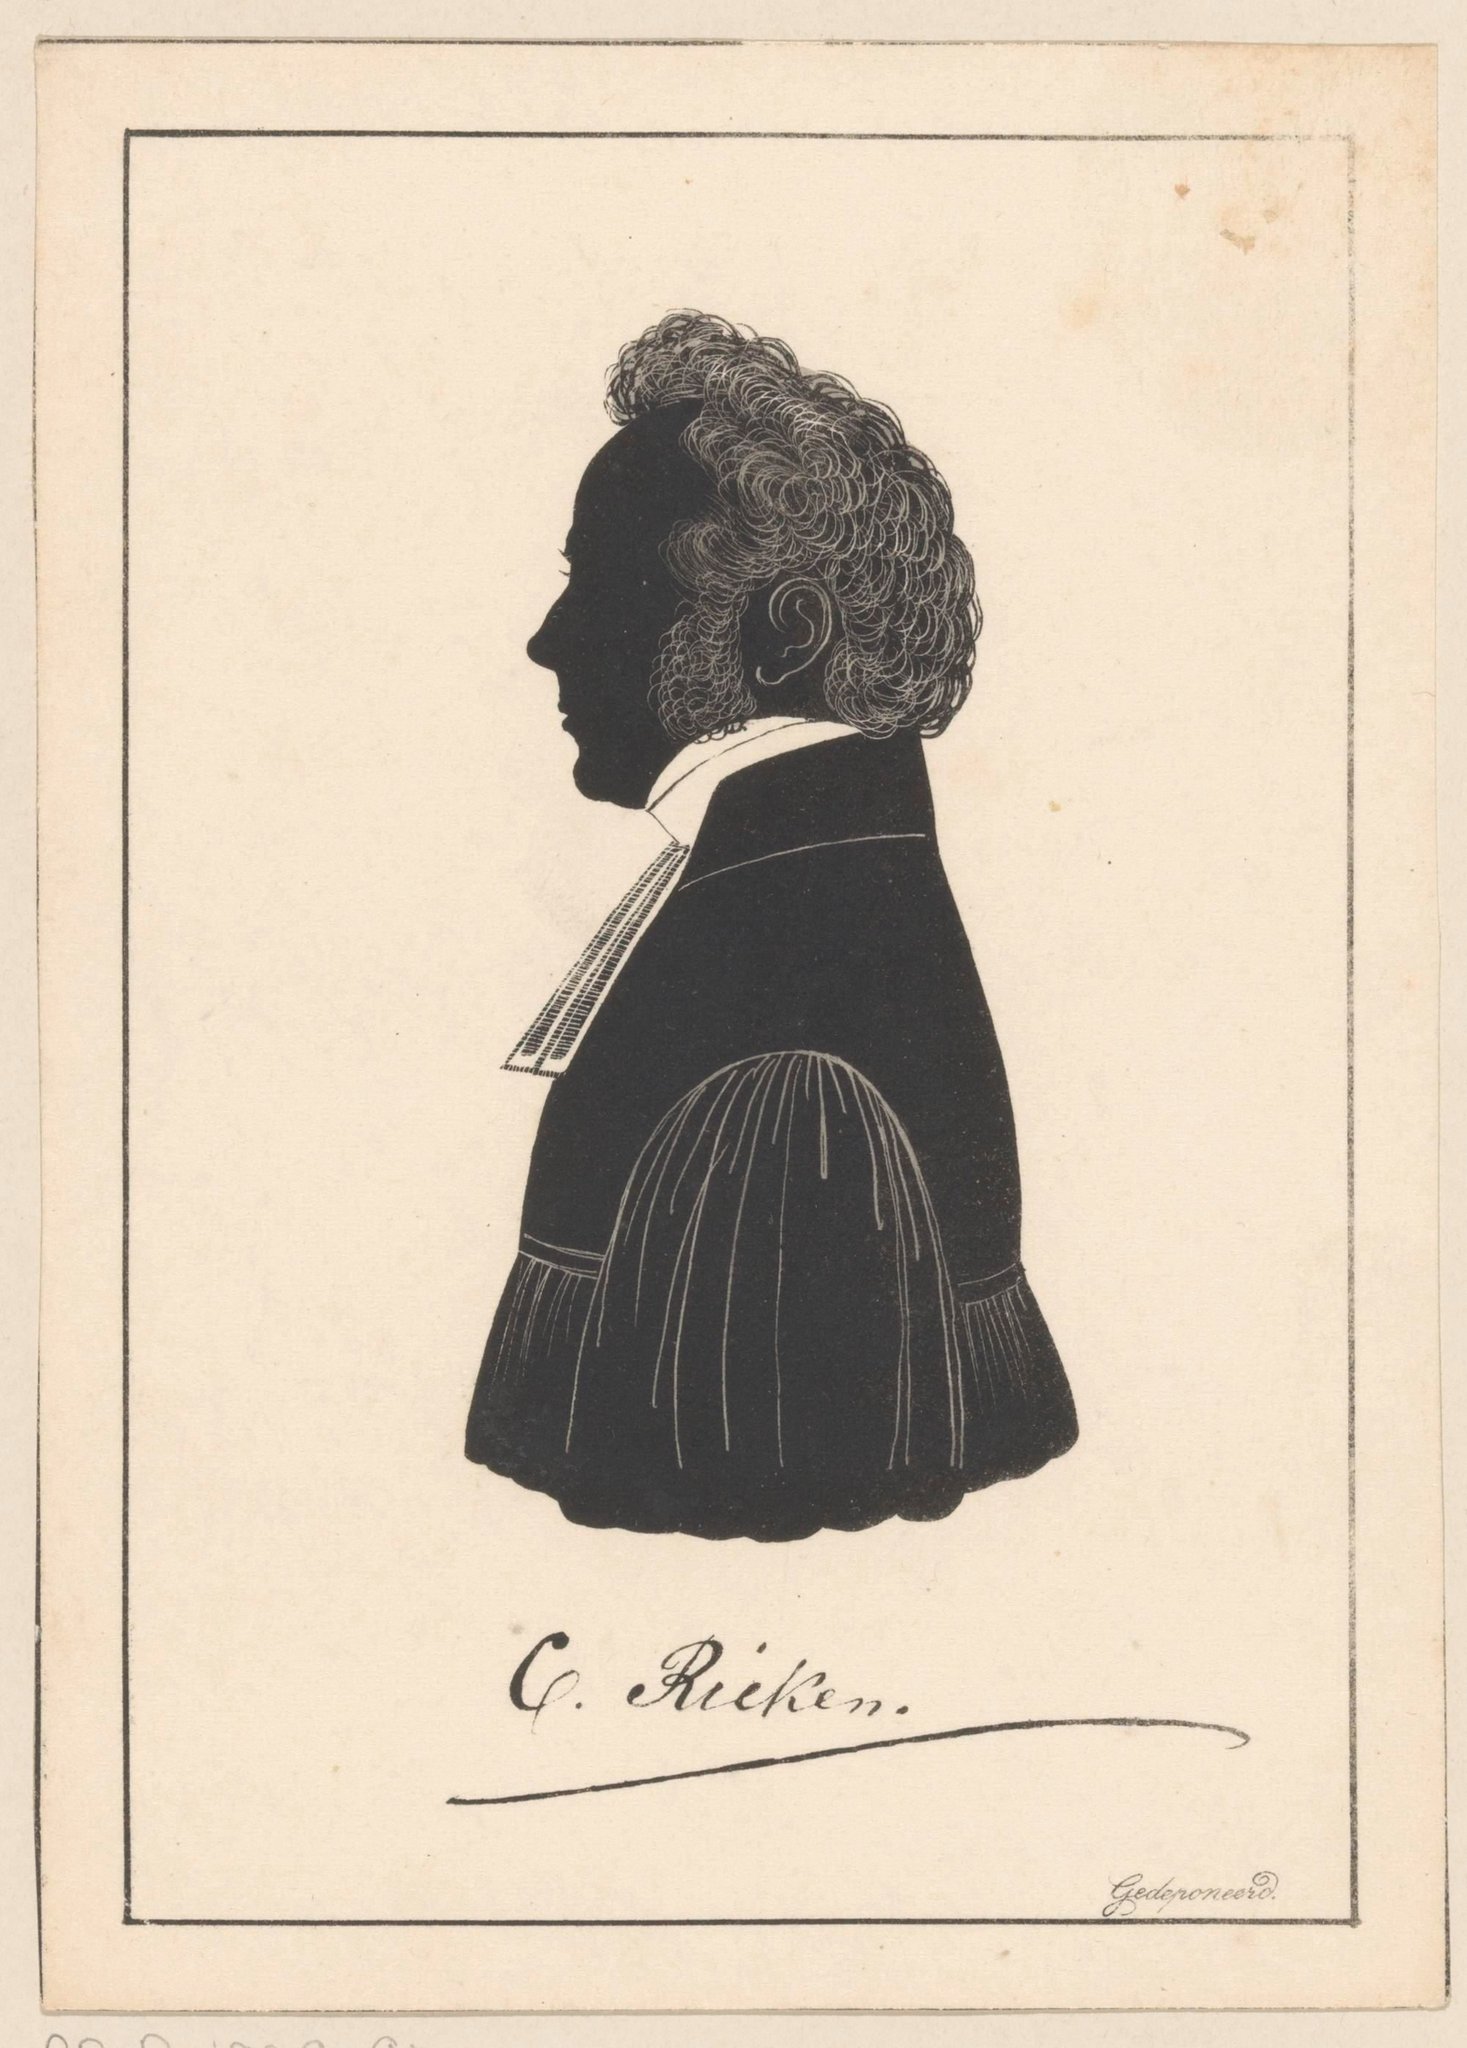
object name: print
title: Silhouetportret van C. Rieken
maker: pieter barbiers (iv)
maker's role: painter, print maker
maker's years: 1798-1848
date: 1809-1848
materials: paper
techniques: hand coloring, lithograph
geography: netherlands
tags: historical persons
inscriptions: collector's mark: Lugt 2228, : ‘Gedeponeerd.’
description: Onder het portret de signatuur van de geportretteerde.